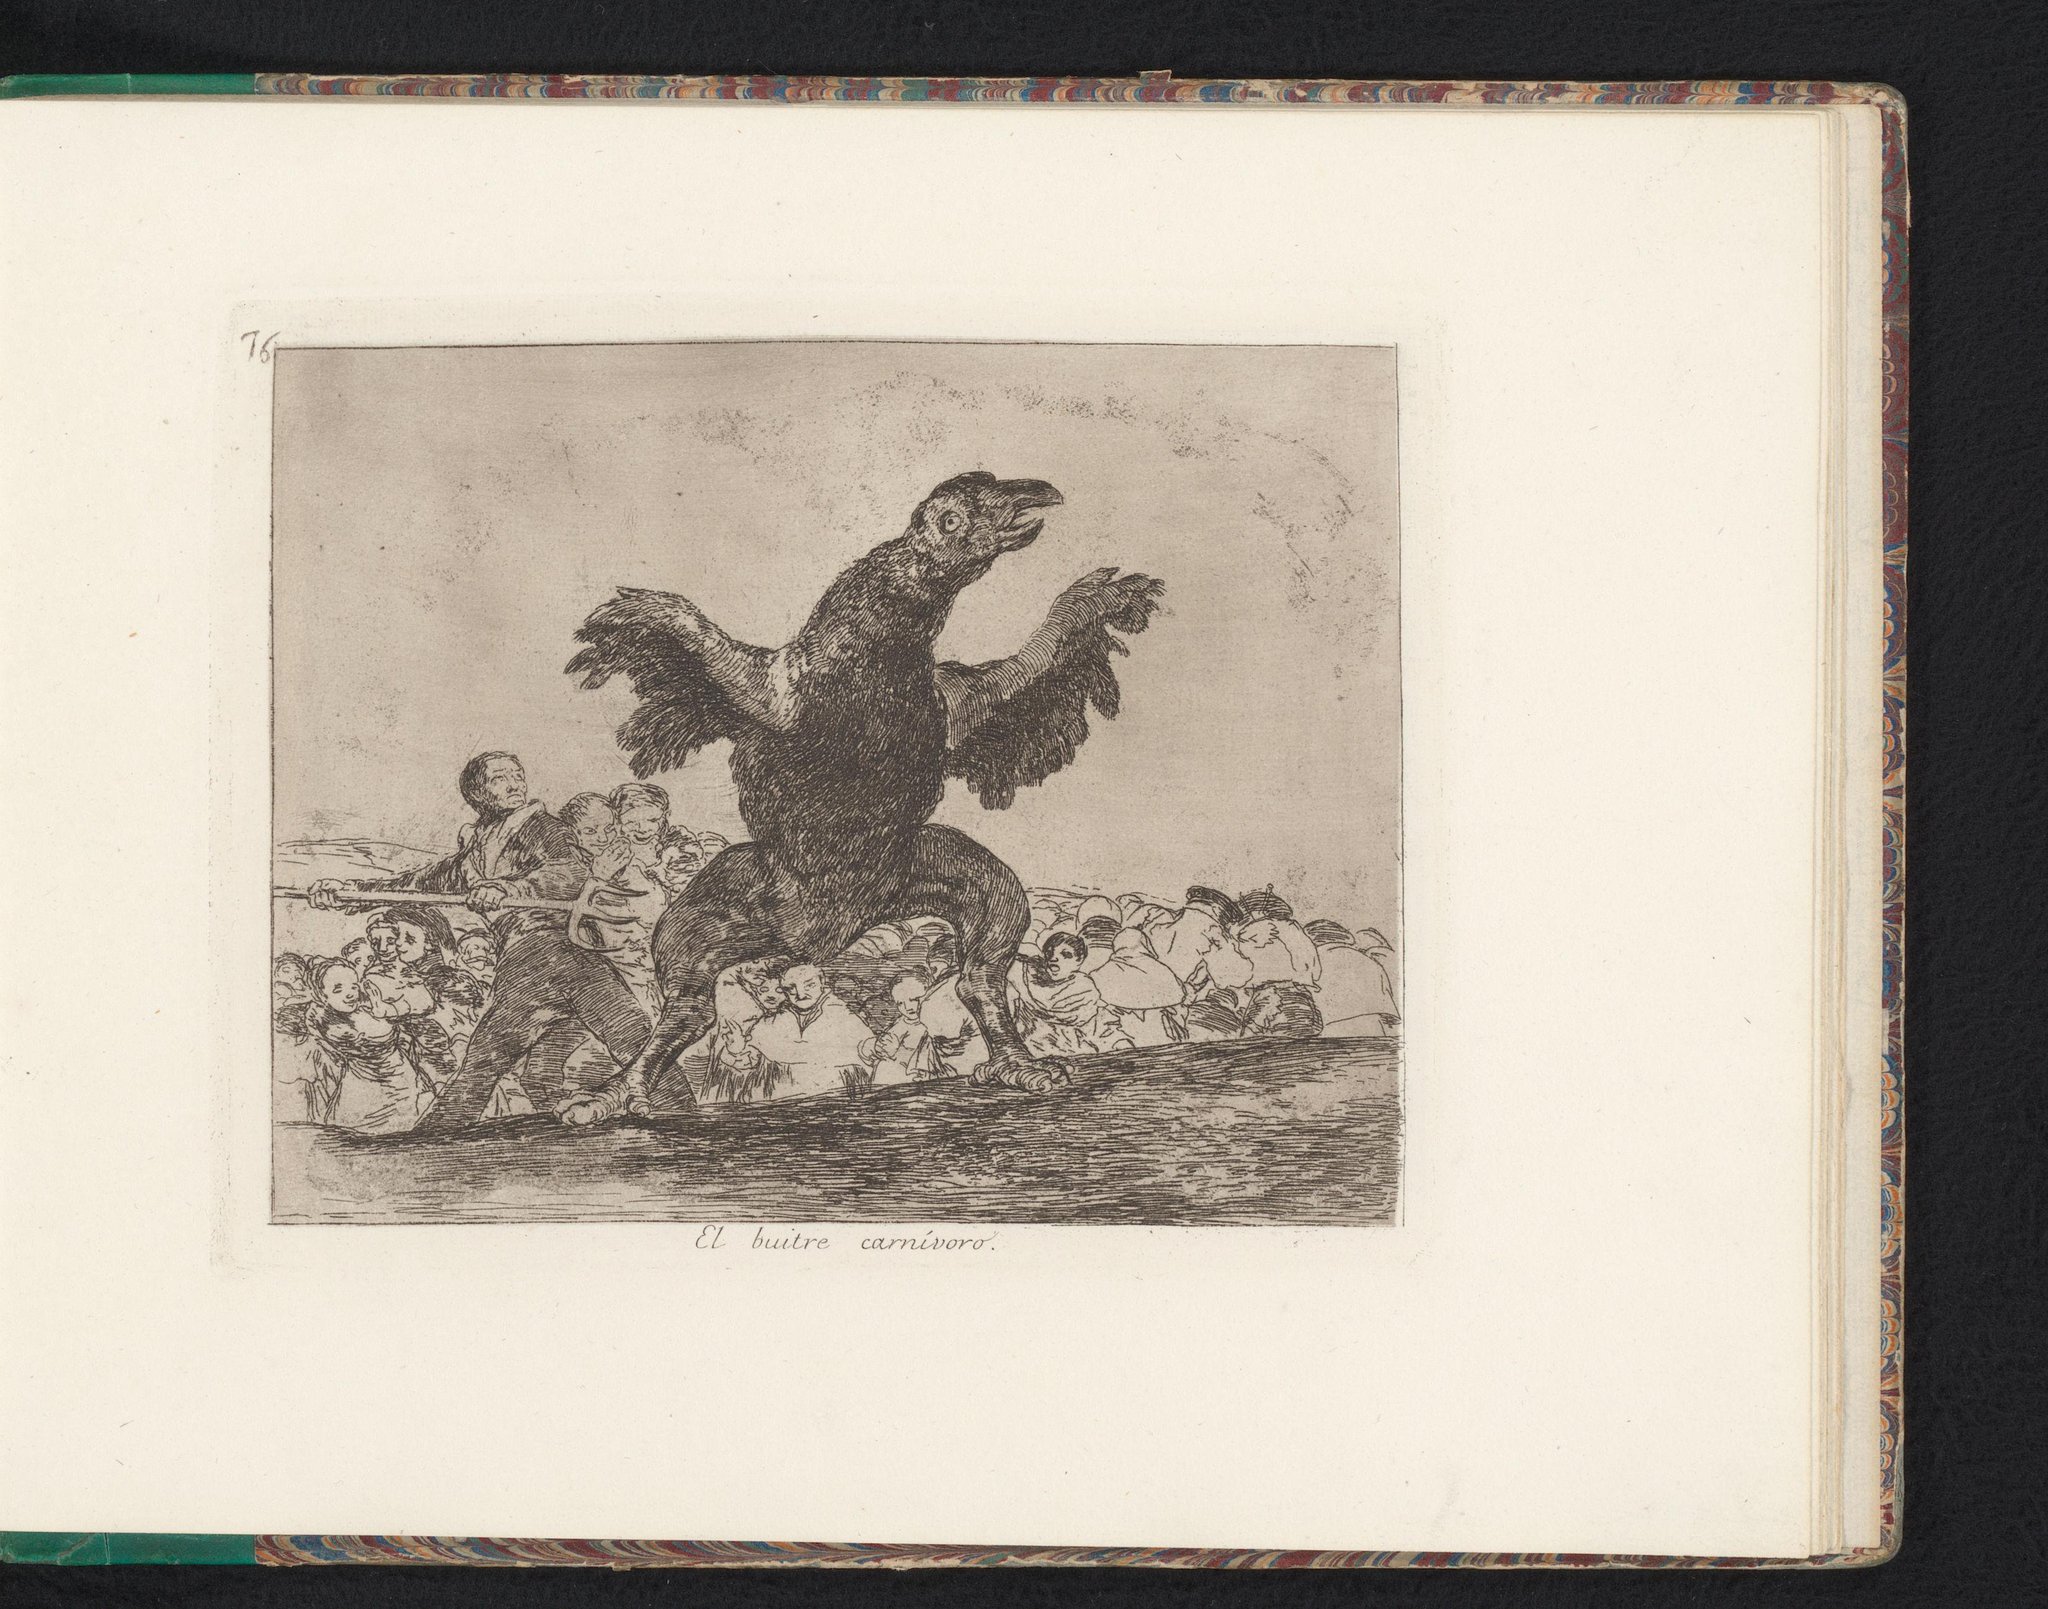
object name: print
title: El buitre carnívoro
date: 1810-1820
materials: paper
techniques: drypoint, engraving, etching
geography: madrid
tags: agricultural implements: pitchfork, predatory birds: vulture, horrors of war, spain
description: Deze prent maakt deel uit van een album.